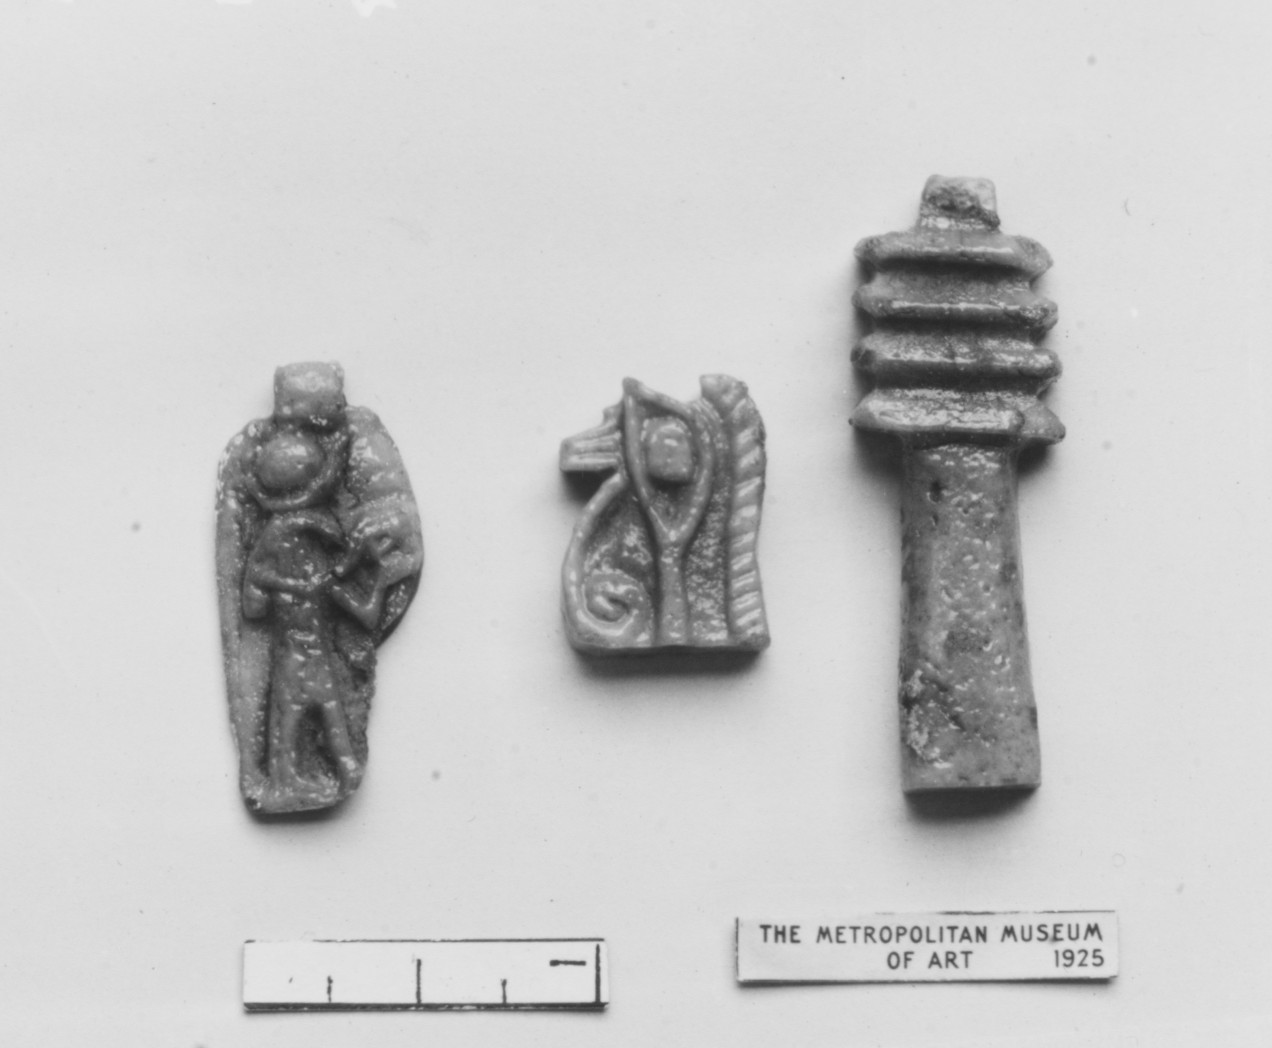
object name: amulet, djedmutesankh, wedjat eye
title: Wedjat Eye Amulet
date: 1000-945 BCE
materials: faience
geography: egypt